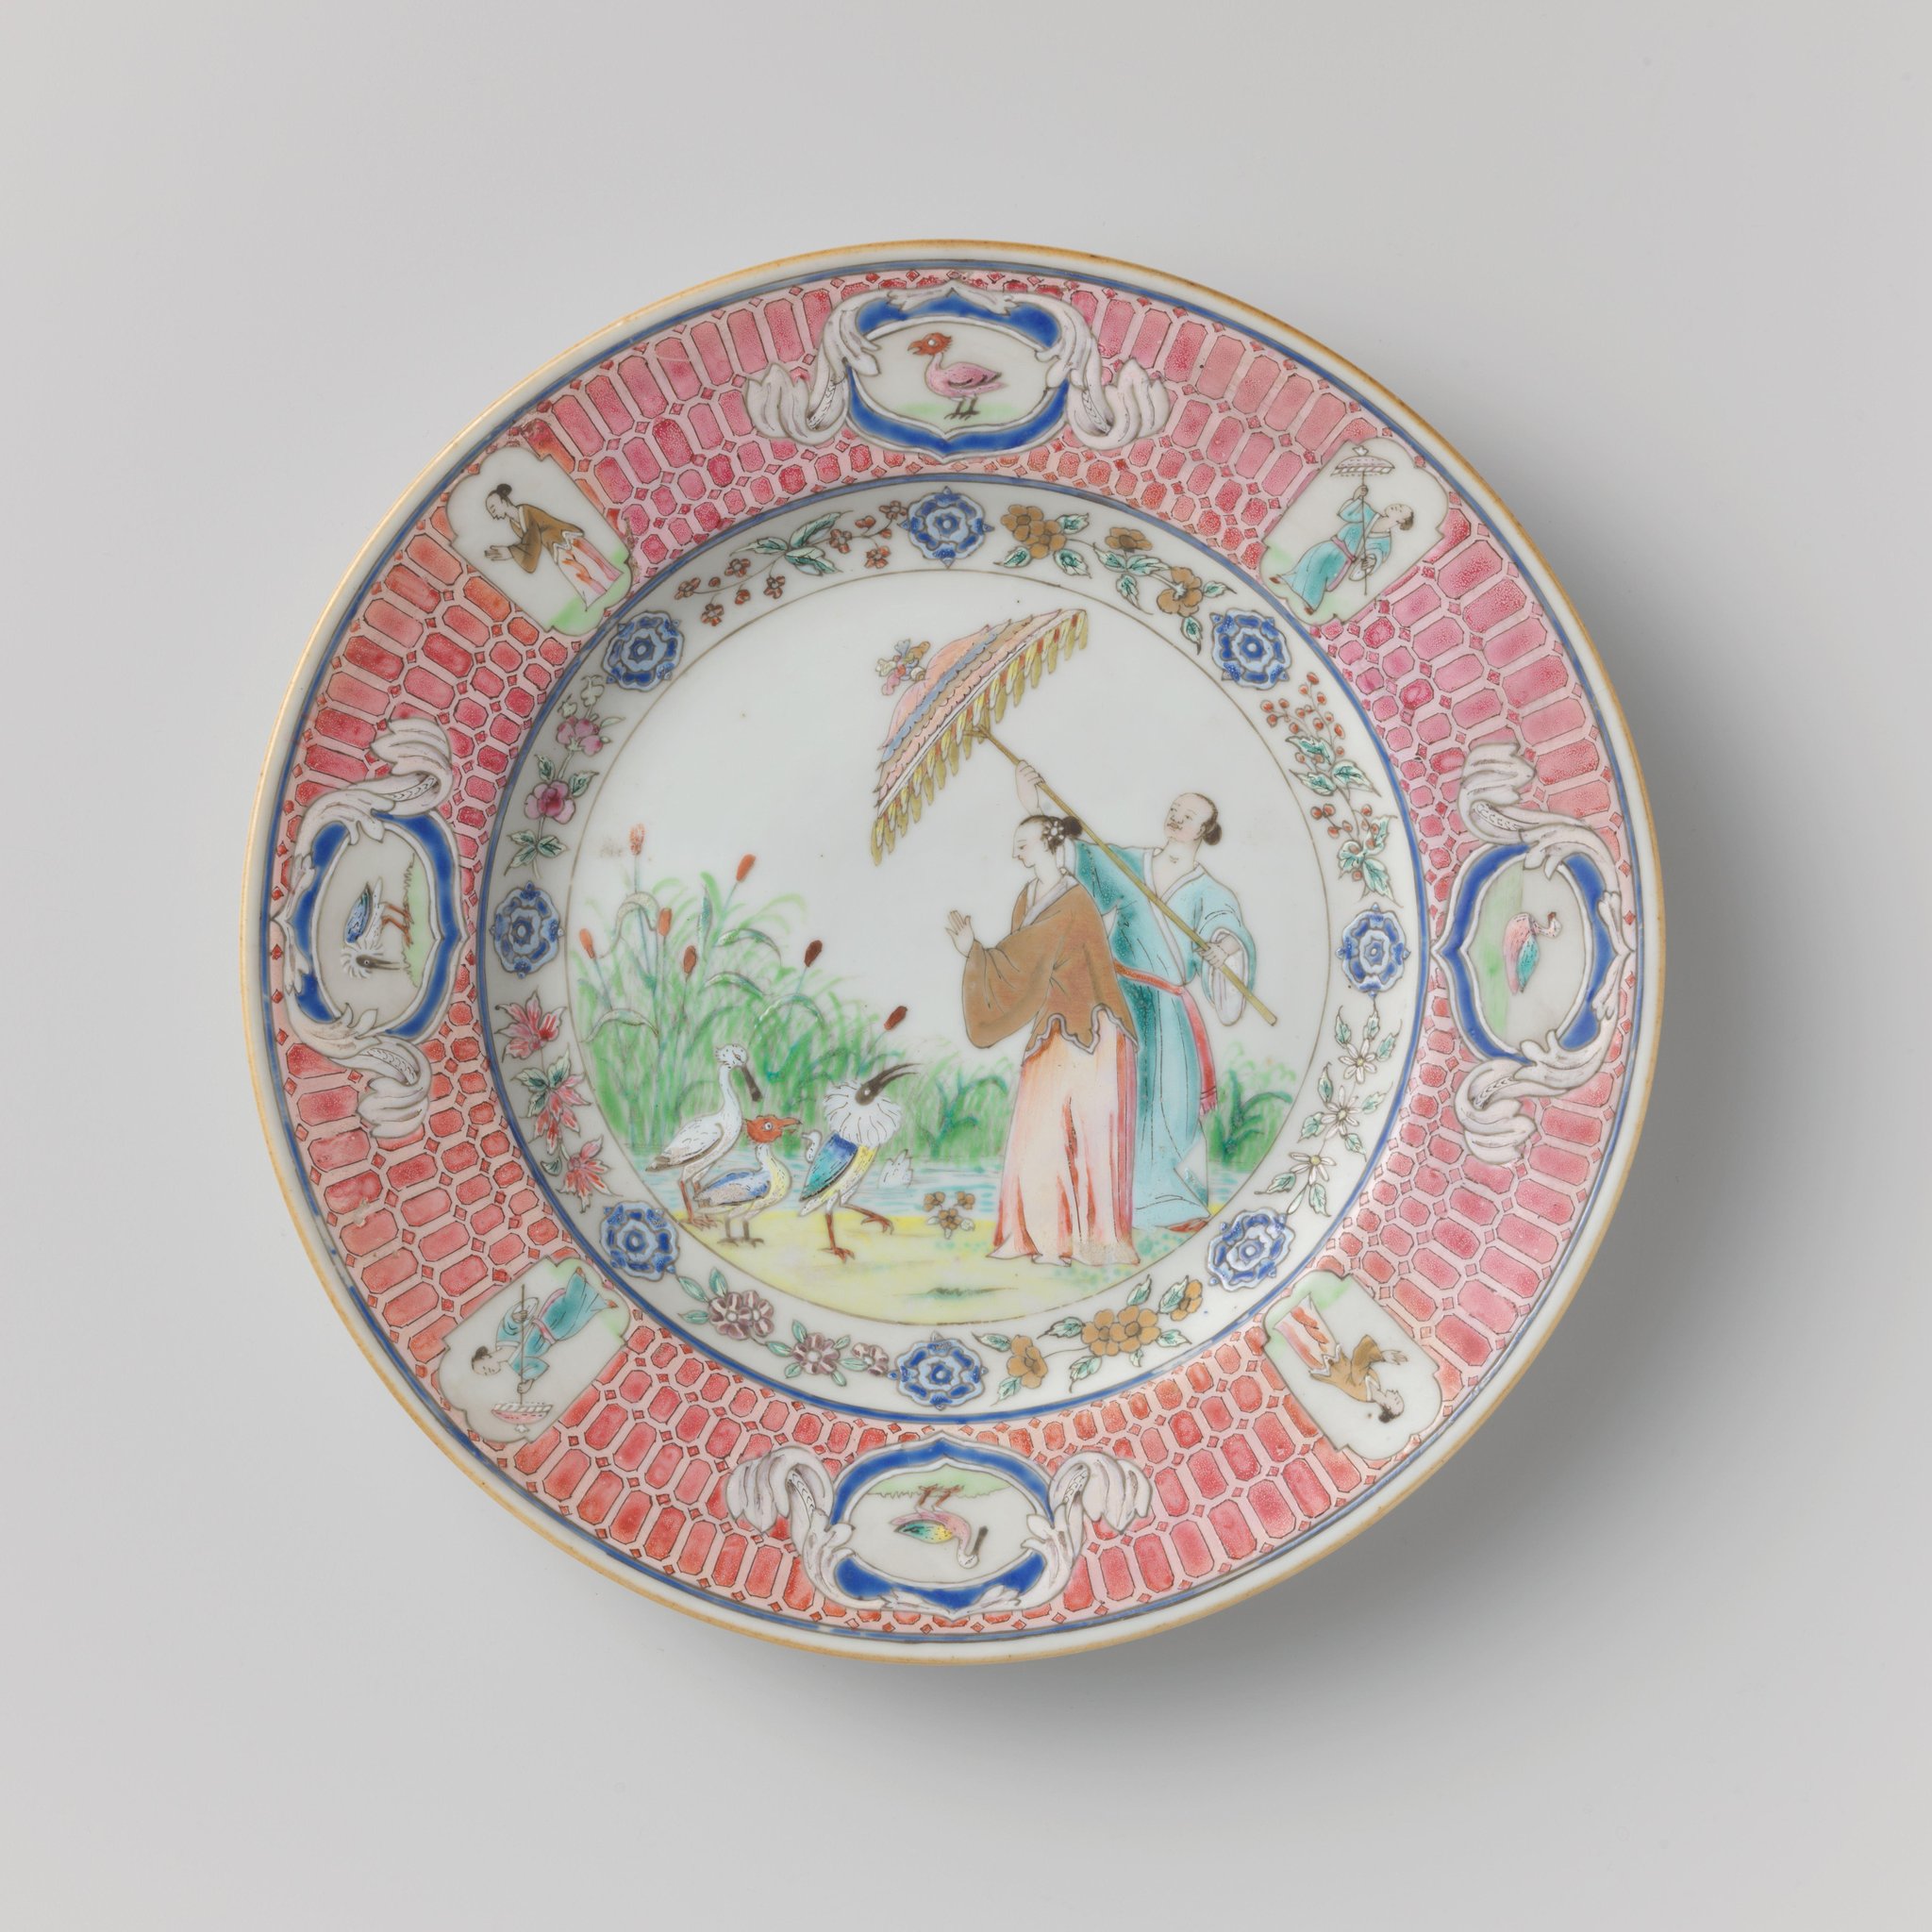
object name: plate dish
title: Plate with an image of The Parasol Lady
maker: Anonymous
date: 1736-1738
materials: glaze, gold, paint, porcelain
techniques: firing, gilding, turning, vitrification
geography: netherlands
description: In 1734 werd door de directeuren van de VOC opdracht gegeven aan de Amsterdamse kunstenaar Cornelis Pronk (1691-1754) een serie ontwerpen te maken voor de decoratie van Chinees porselein. In totaal maakte Pronk vier verschillende tekeningen. Twee ontwerpen die Pronk maakte kunnen met zekerheid aan hem worden toegeschreven, namelijk de Parasoldames en de Doctoren (zie bijvoorbeeld AK-NM-13703). Tekeningen met deze ontwerpen bevinden zich in het Prentenkabinet te Amsterdam. Het vierde ontwerp is het Prieel( zie bijvoorbeeld AK-NM-13528). Van dit ontwerp is geen tekening bewaard gebleven maar beschreven in de VOC archieven. Dus zijn de vele porseleinen voorwerpen met dit ontwerp te herleiden naar Pronk. Het ontwerp van de Boogschutter (zie bijvoorbeeld AK-RBK-1959-27) zou het derde ontwerp kunnen zijn omdat dit qua stijl overeenkomt met de andere ontwerpen. De tekeningen werden via Batavia naar Kanton gezonden in 1736. De ontwerpen van Pronk waren populair, en zijn zelfs in een latere periode terug te vinden op Japans porselein.